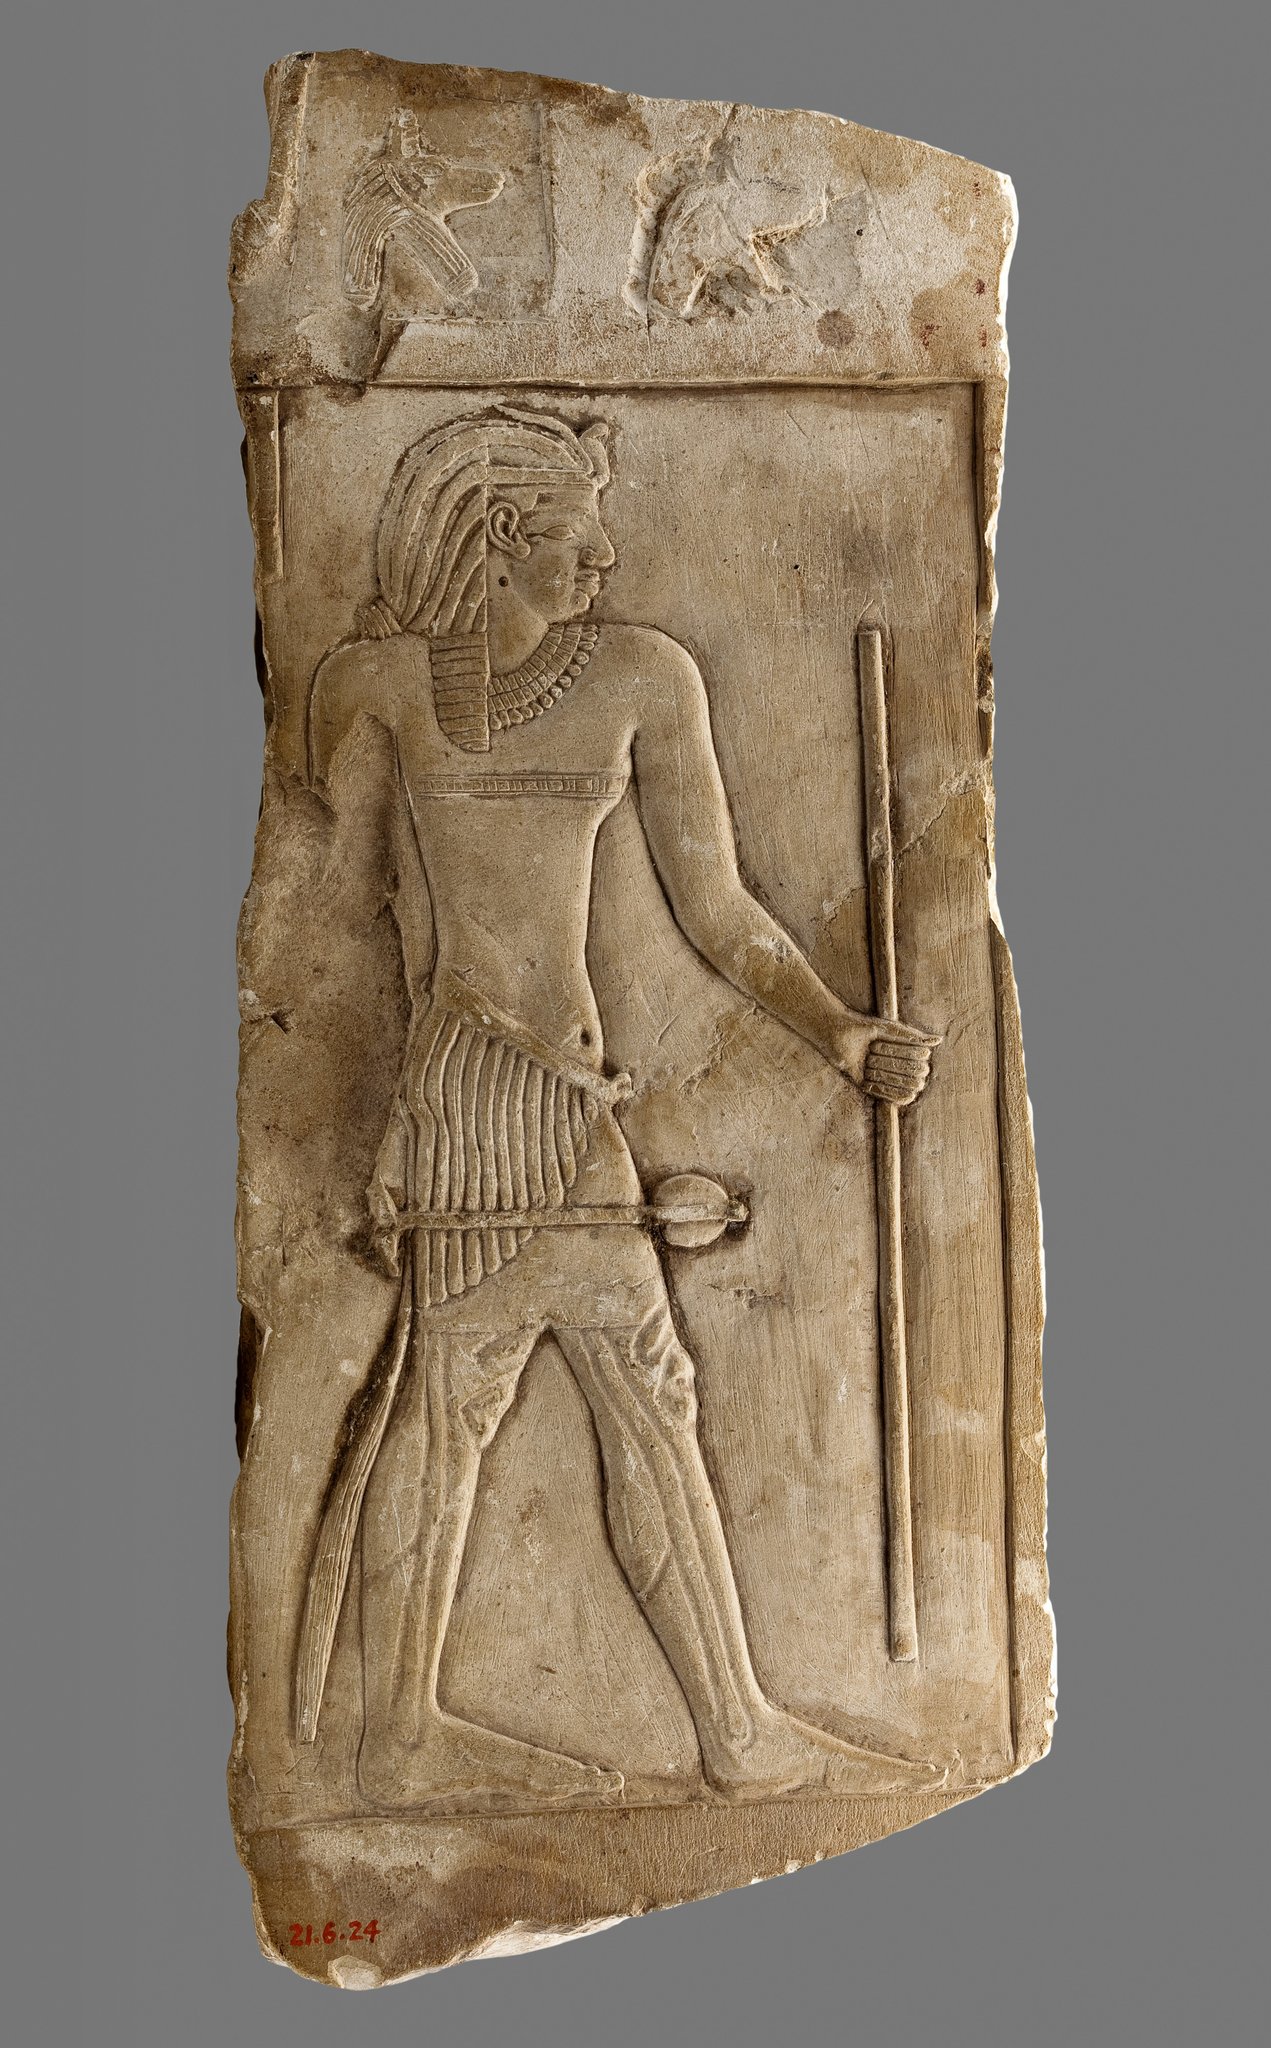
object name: sculptor's model votive, king, jackal bust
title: Sculptor's model/votive depicting a king and jackal busts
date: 664-525 BCE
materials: limestone, paint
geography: egypt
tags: kings,men,jackals